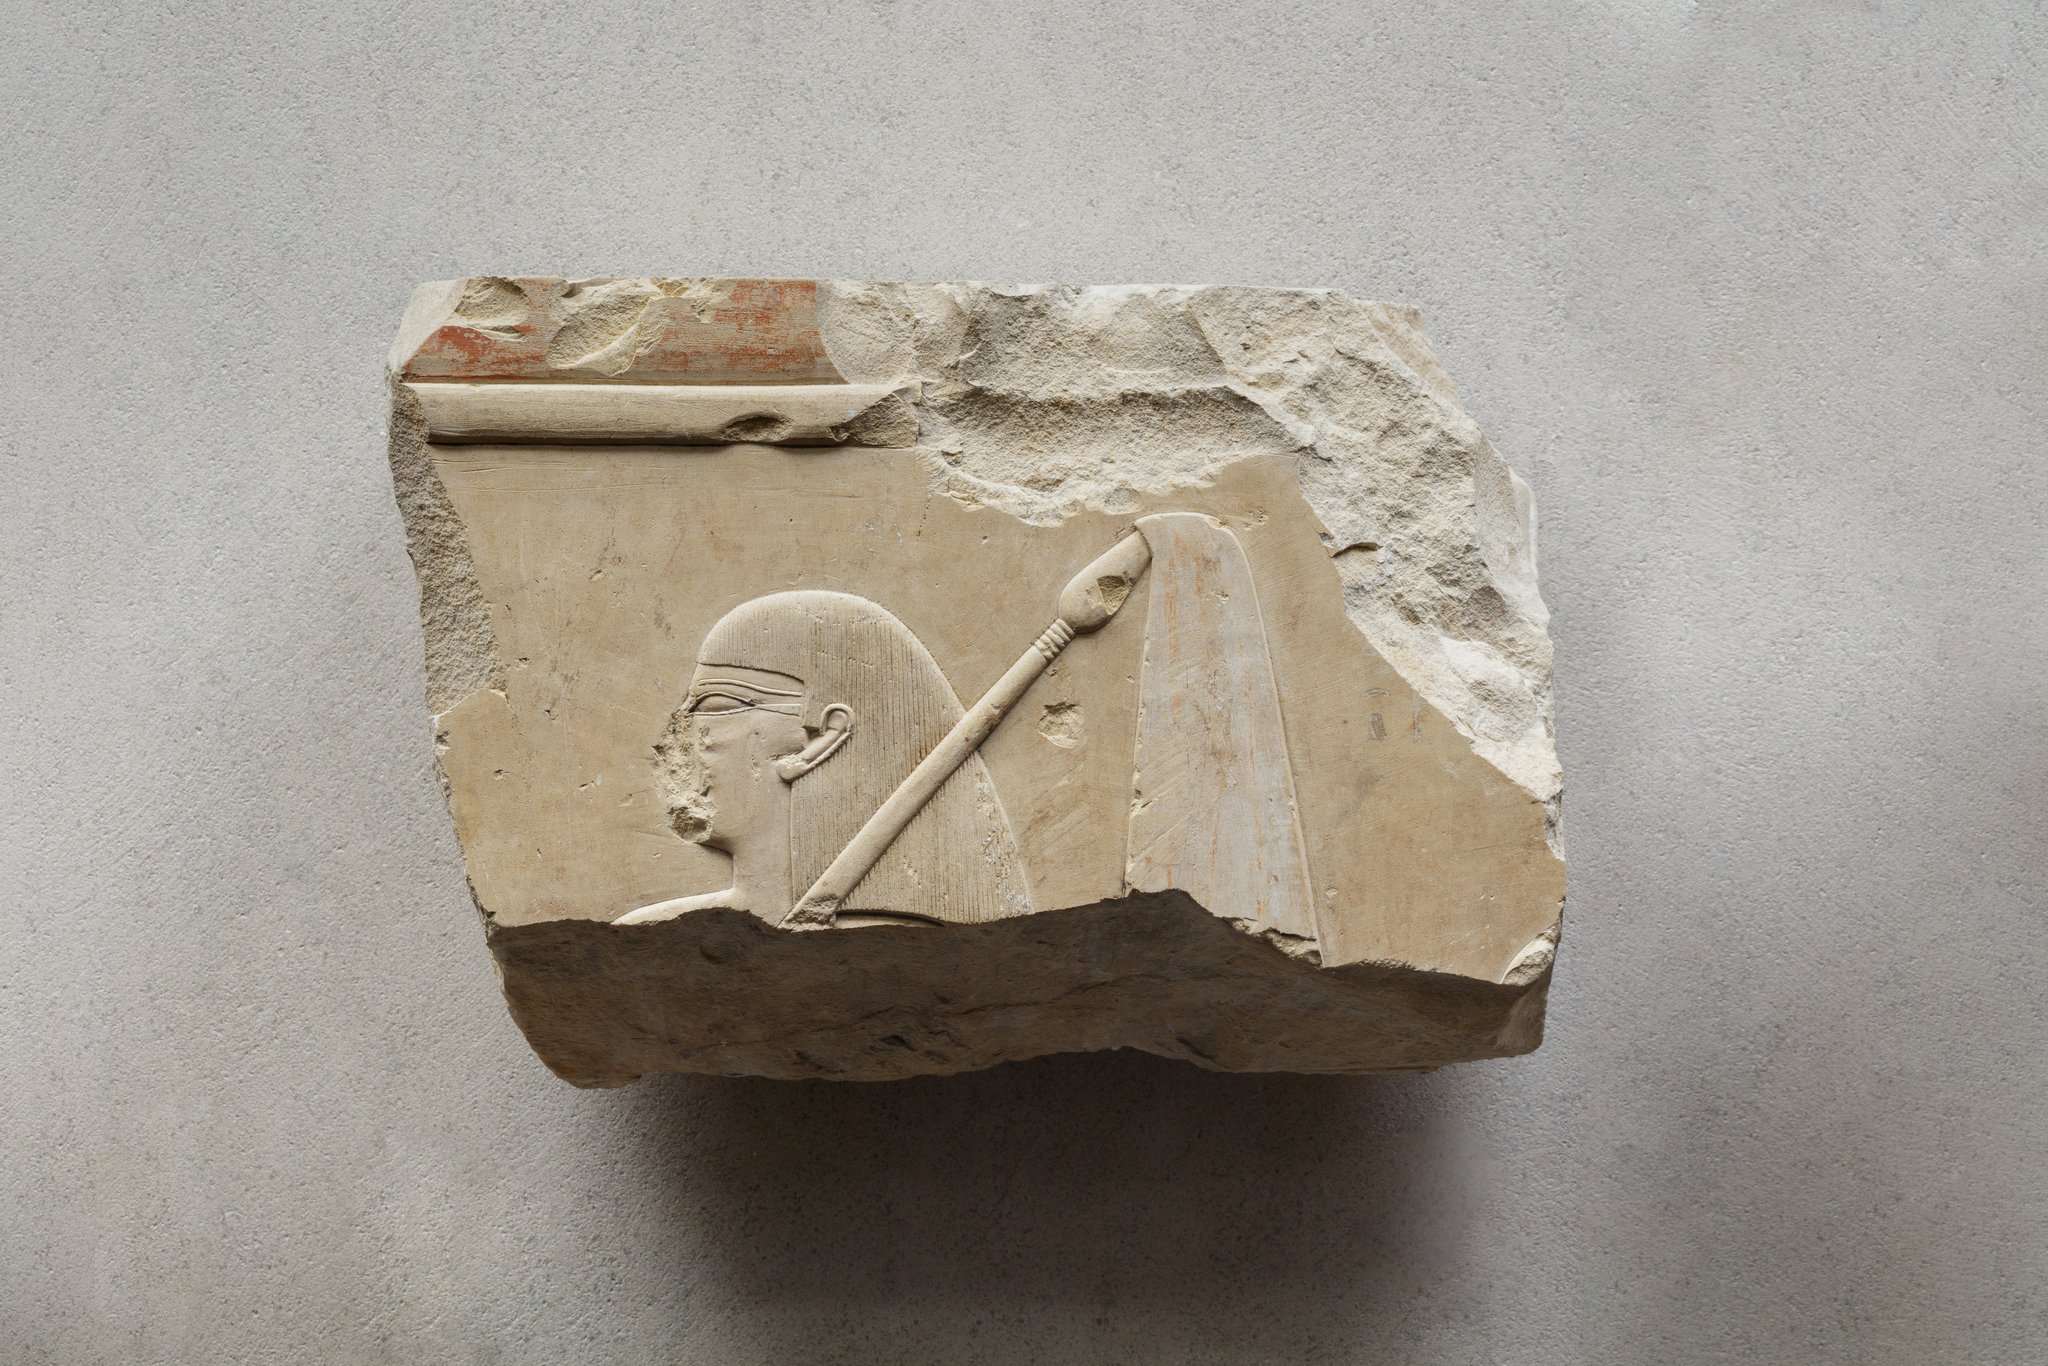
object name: relief, female attendant with sunshade, neferu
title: Relief of female attendant with sunshade - see 26.3.353-3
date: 2051-2030 BCE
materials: limestone, paint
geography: egypt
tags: women